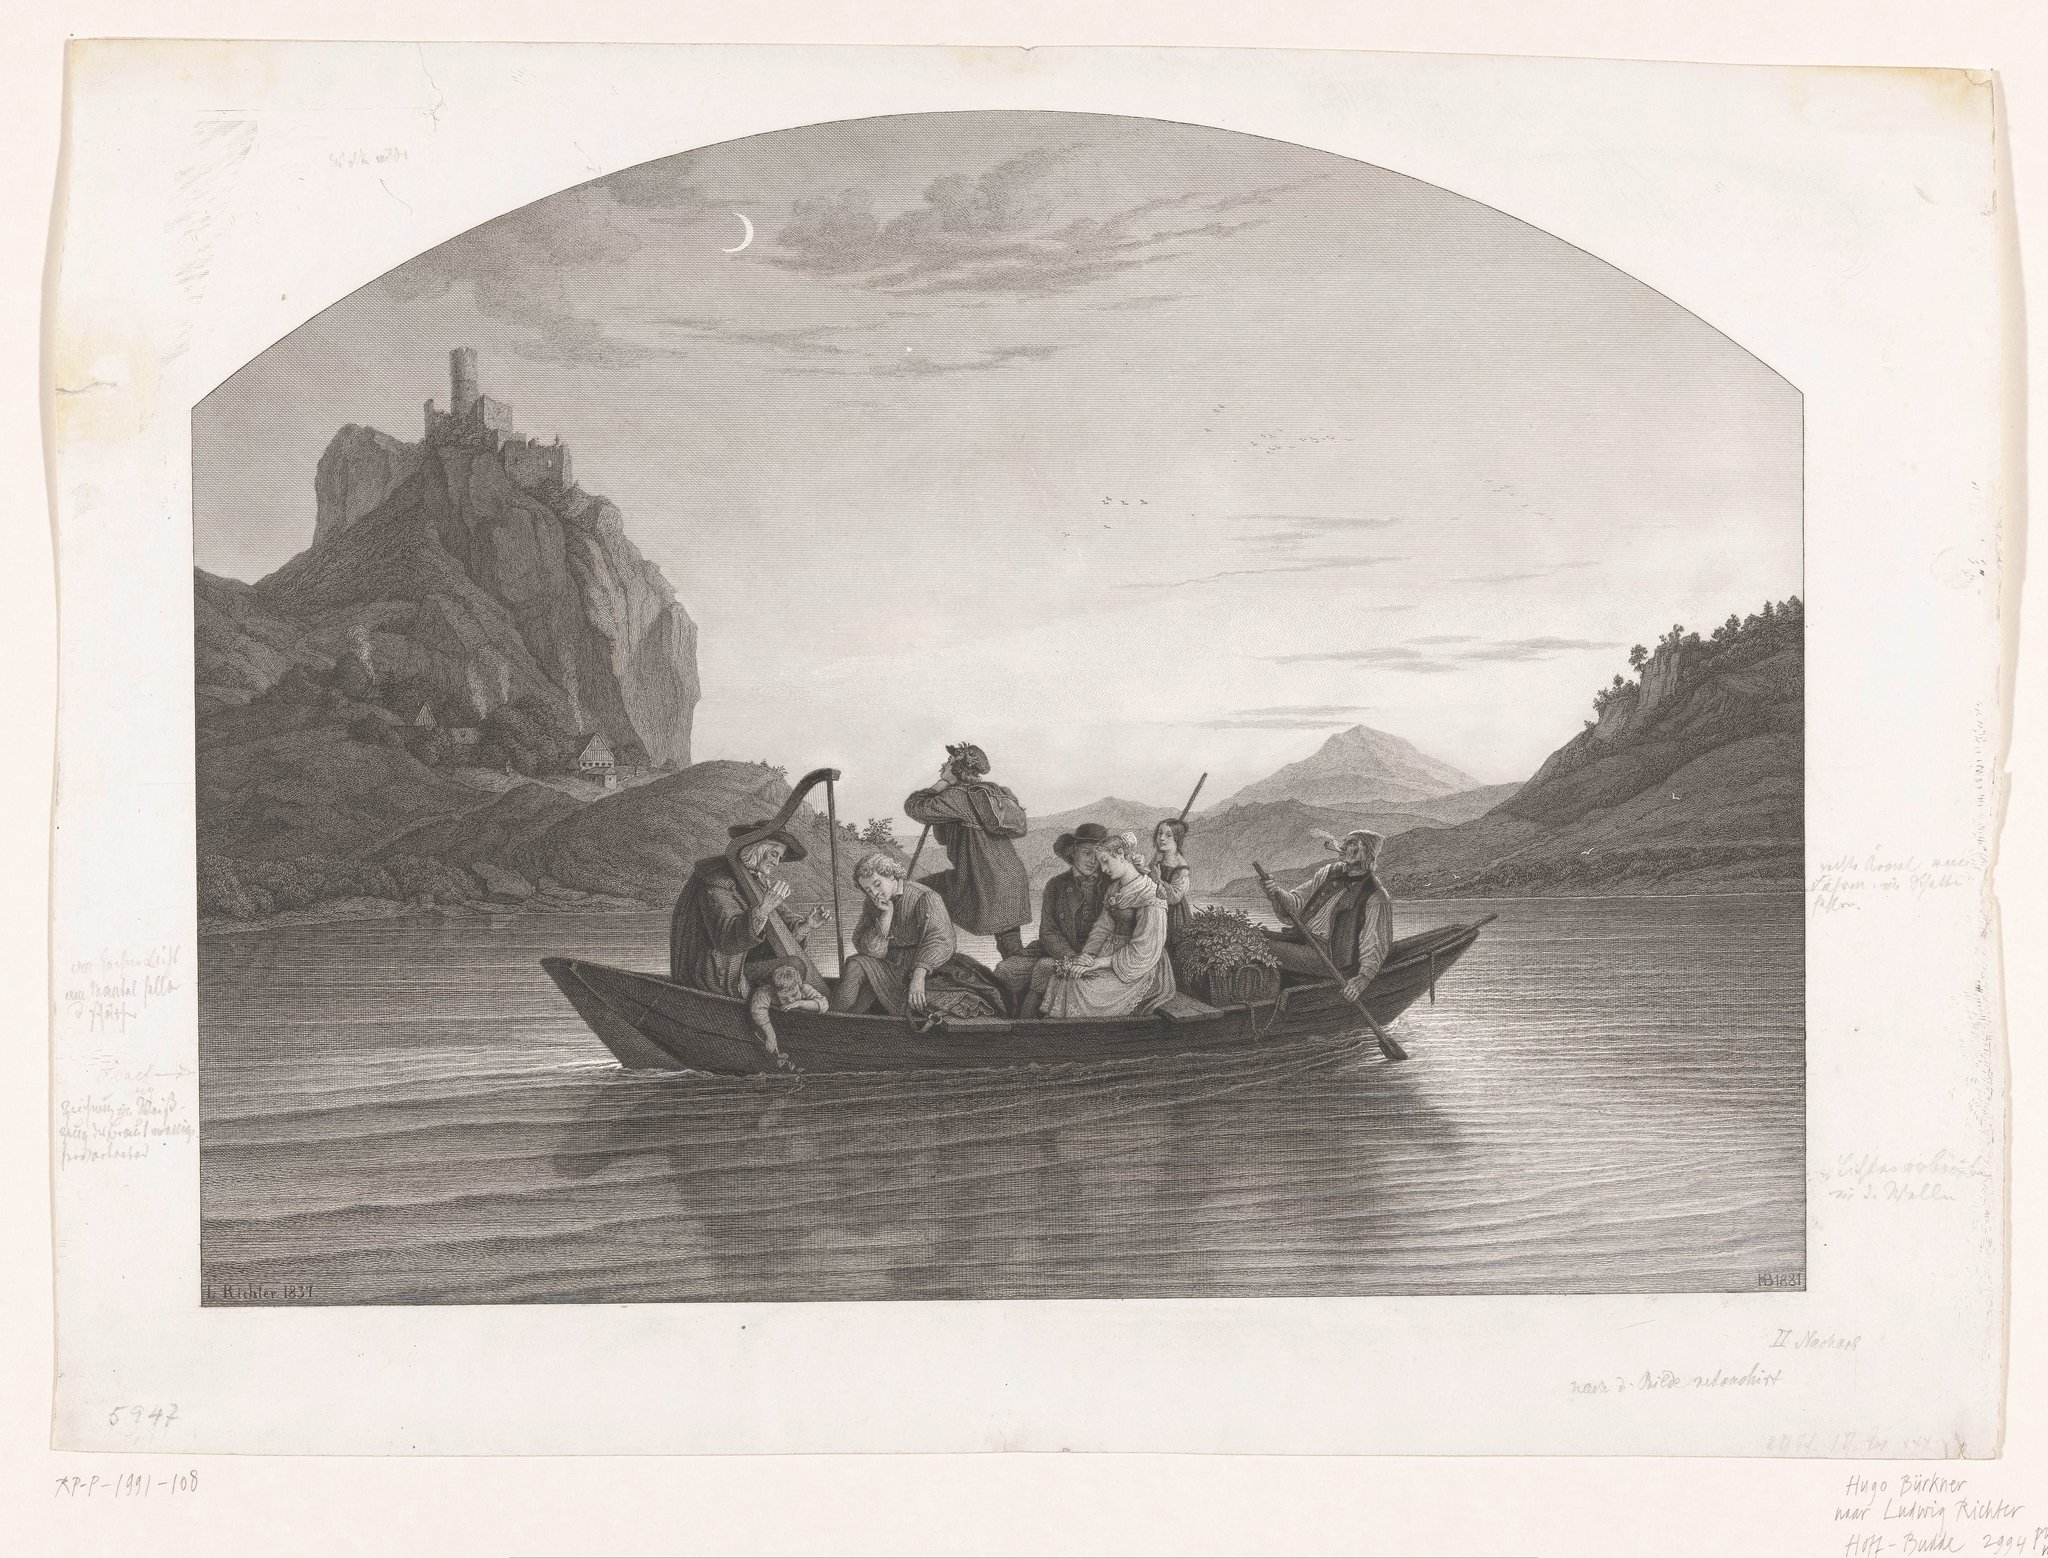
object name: print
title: Gezelschap in een boot op de Elbe, in de achtergrond ruïne Schreckenstein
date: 1881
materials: paper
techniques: engraving, etching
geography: dresden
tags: river, rowing-boat, canoe, etc., harp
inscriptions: inscription, collector's mark: Lugt 2228, collector's mark: Lugt 2760